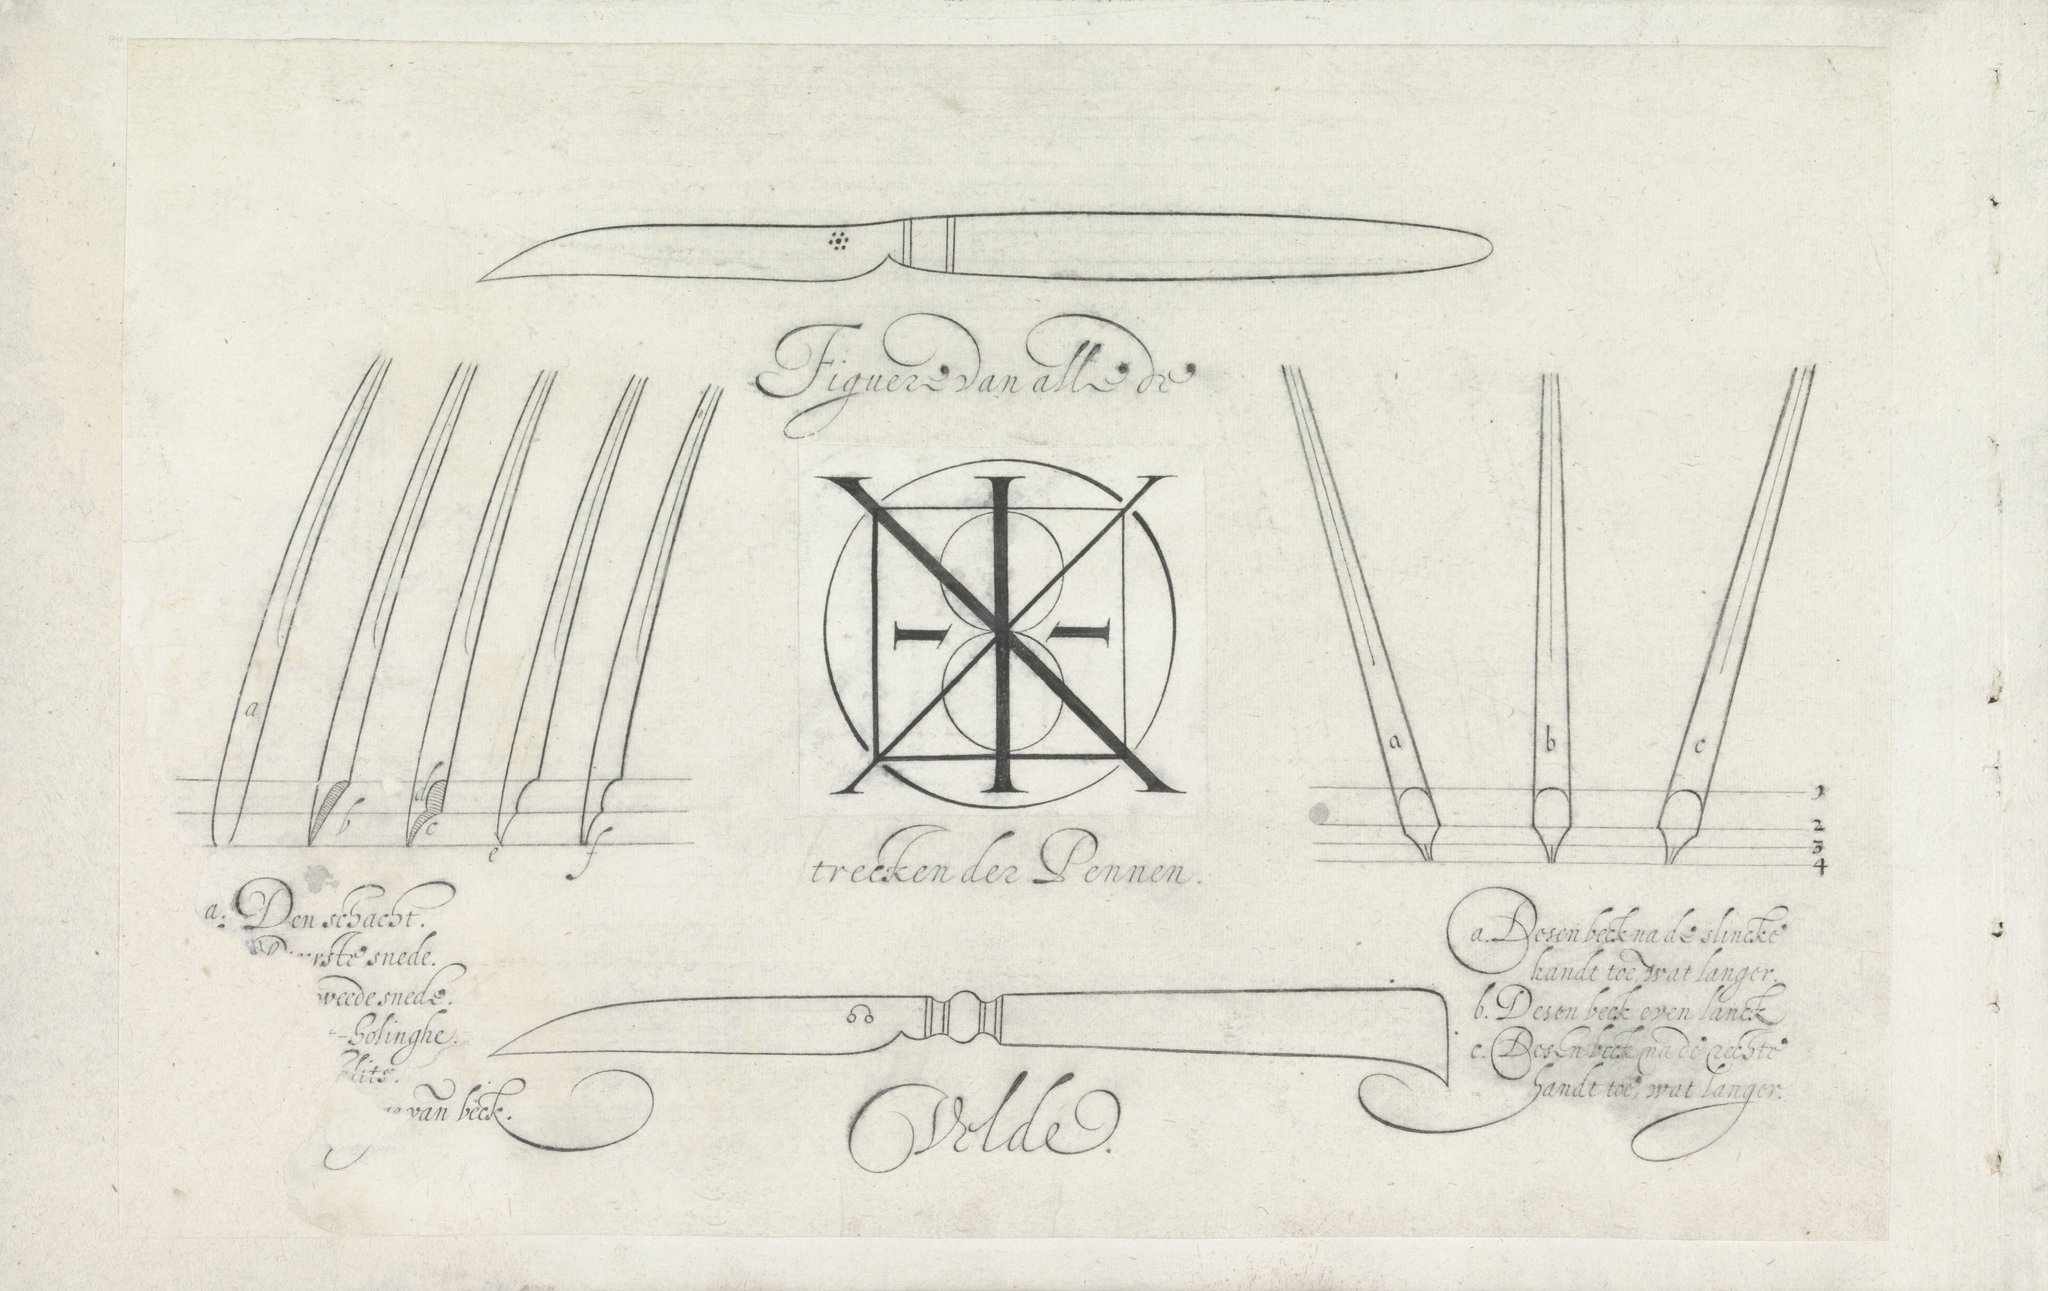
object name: album leaf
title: Spieghel der schrijfkonste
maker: jan van de velde (i)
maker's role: painter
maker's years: 1568-1623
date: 1605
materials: ink, paper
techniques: calligraphy, pen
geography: rotterdam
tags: calligraphy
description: Het snijden van een rietpen. In acht stappen wordt verteld hoe de punt gesneden moet worden. Daaronder twee legenda's. Boven en onder een mes. De figuur in het midden is toegevoegd. De tekening maakt deel uit van een album.